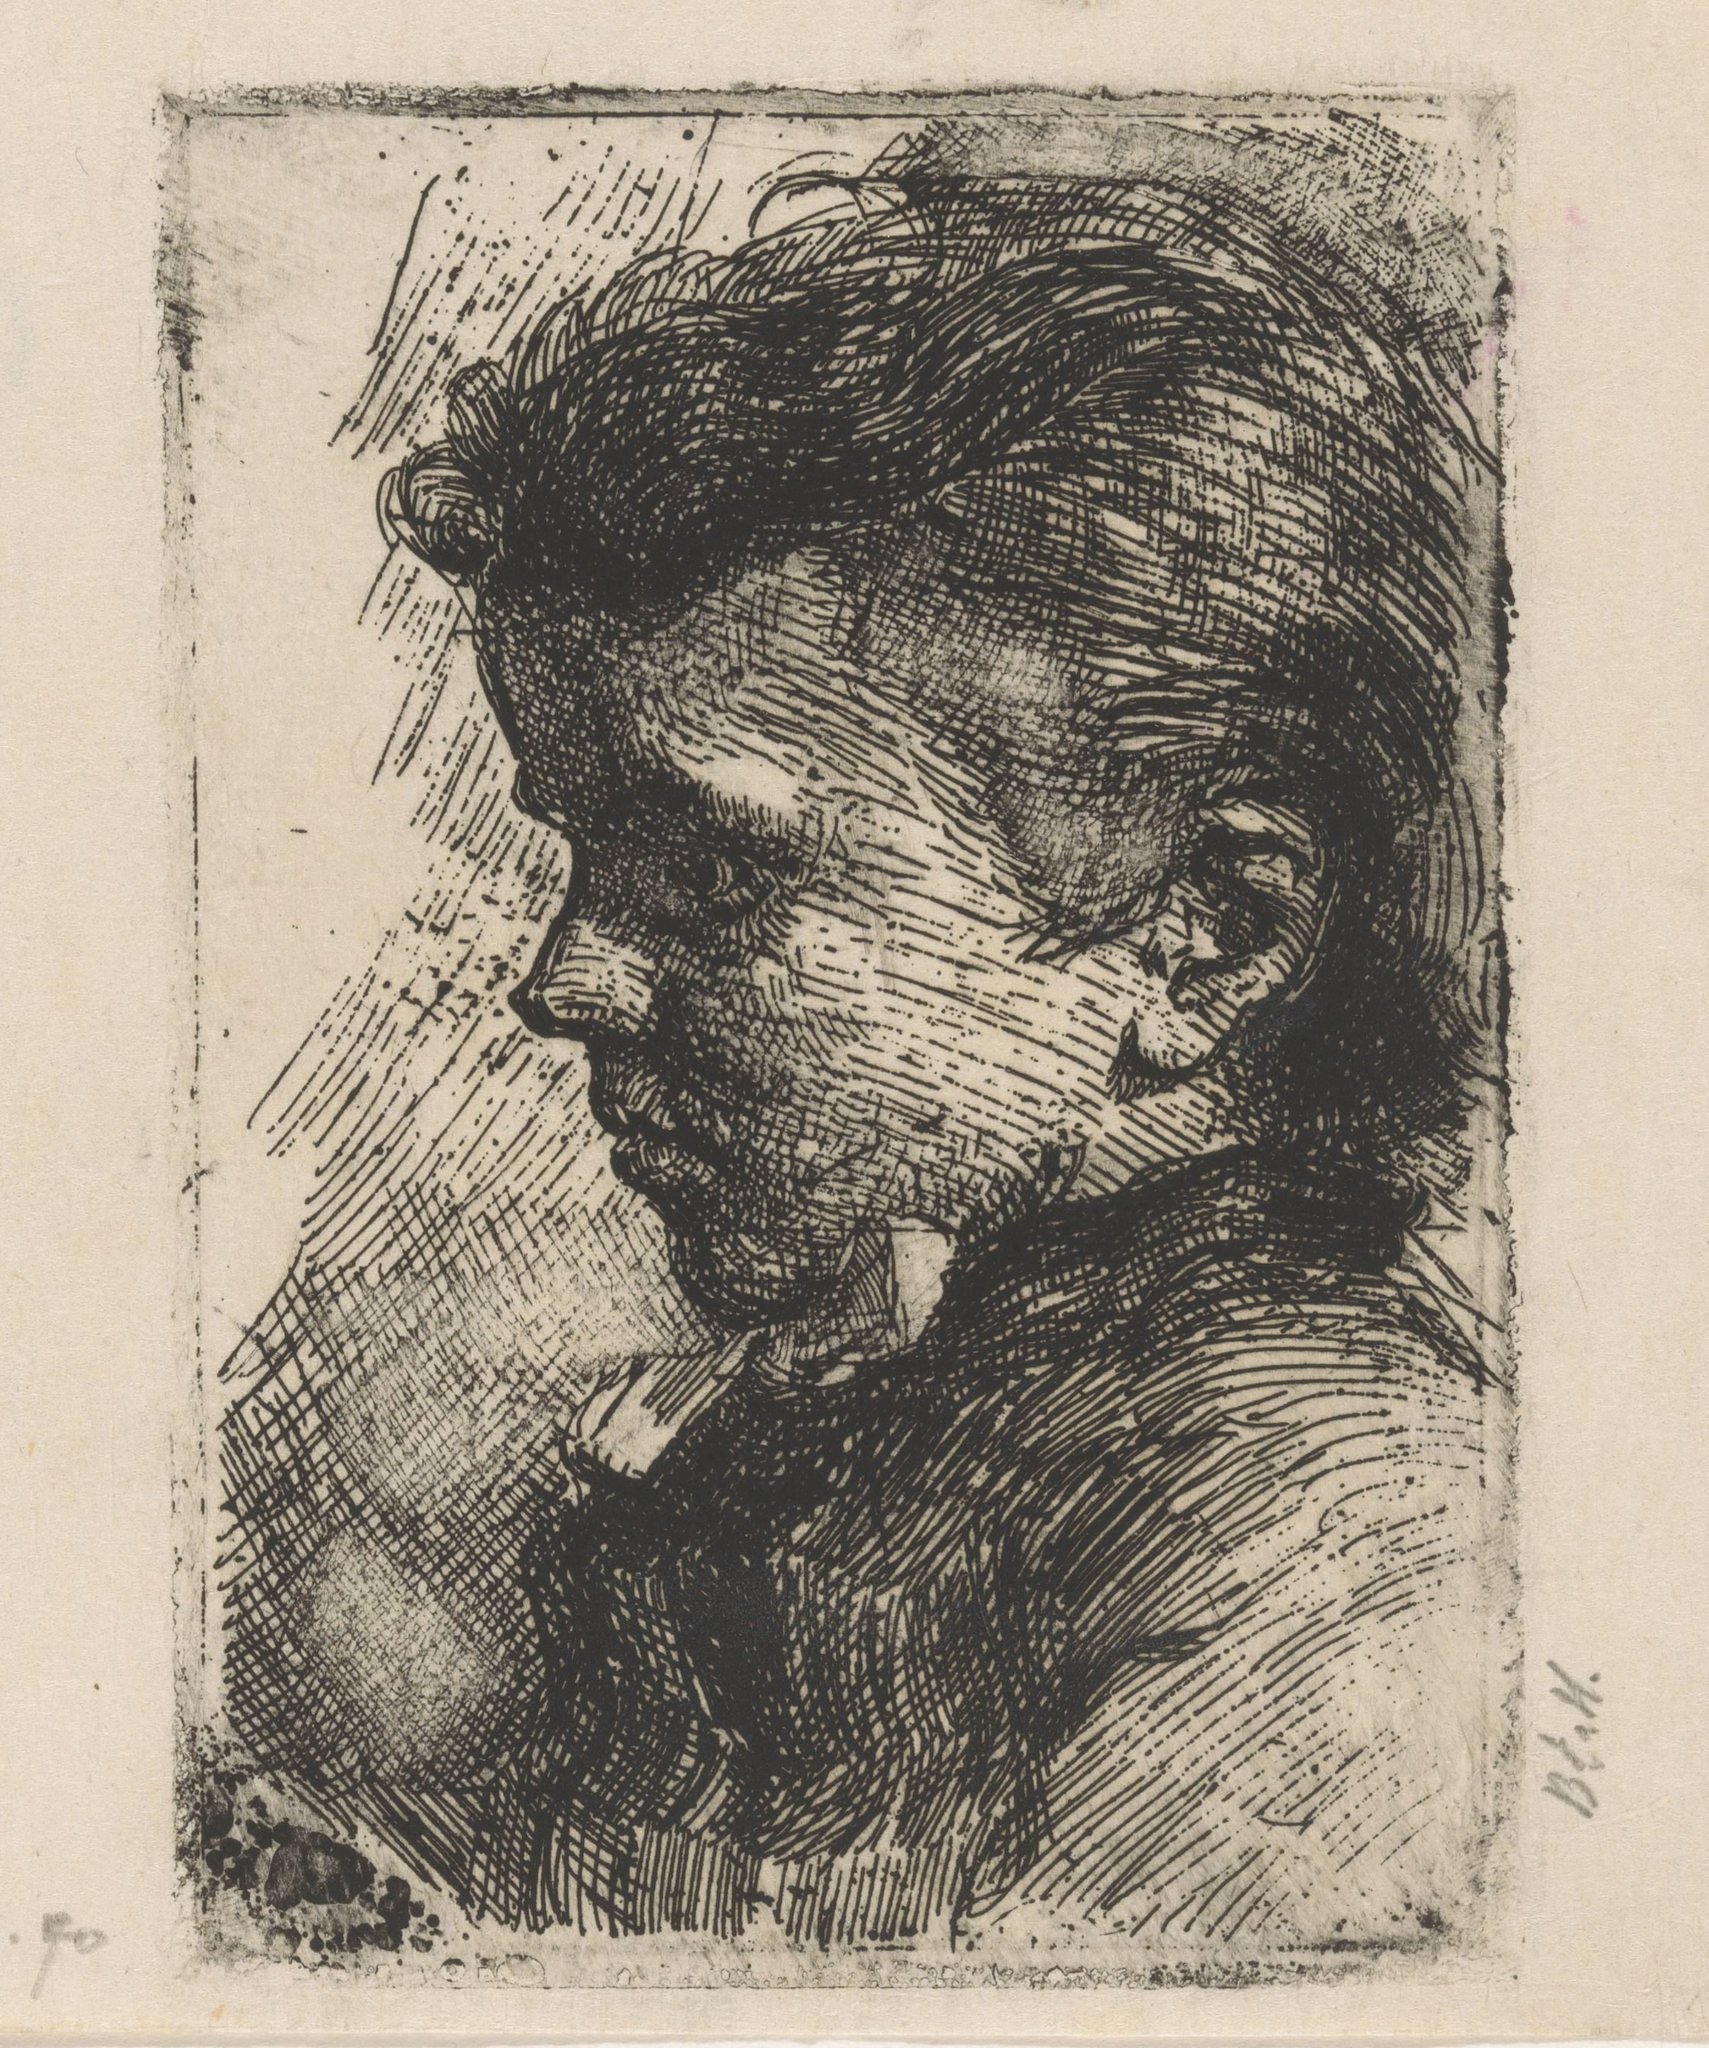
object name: print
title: Portret van een meisje naar links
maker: barbara elisabeth van houten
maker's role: draughtsman, print maker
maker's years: 1862-1950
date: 1877-1950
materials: paper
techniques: etching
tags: girl (child between toddler and youth)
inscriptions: : ‘bloemenmeisje’, collector's mark: Lugt 2228